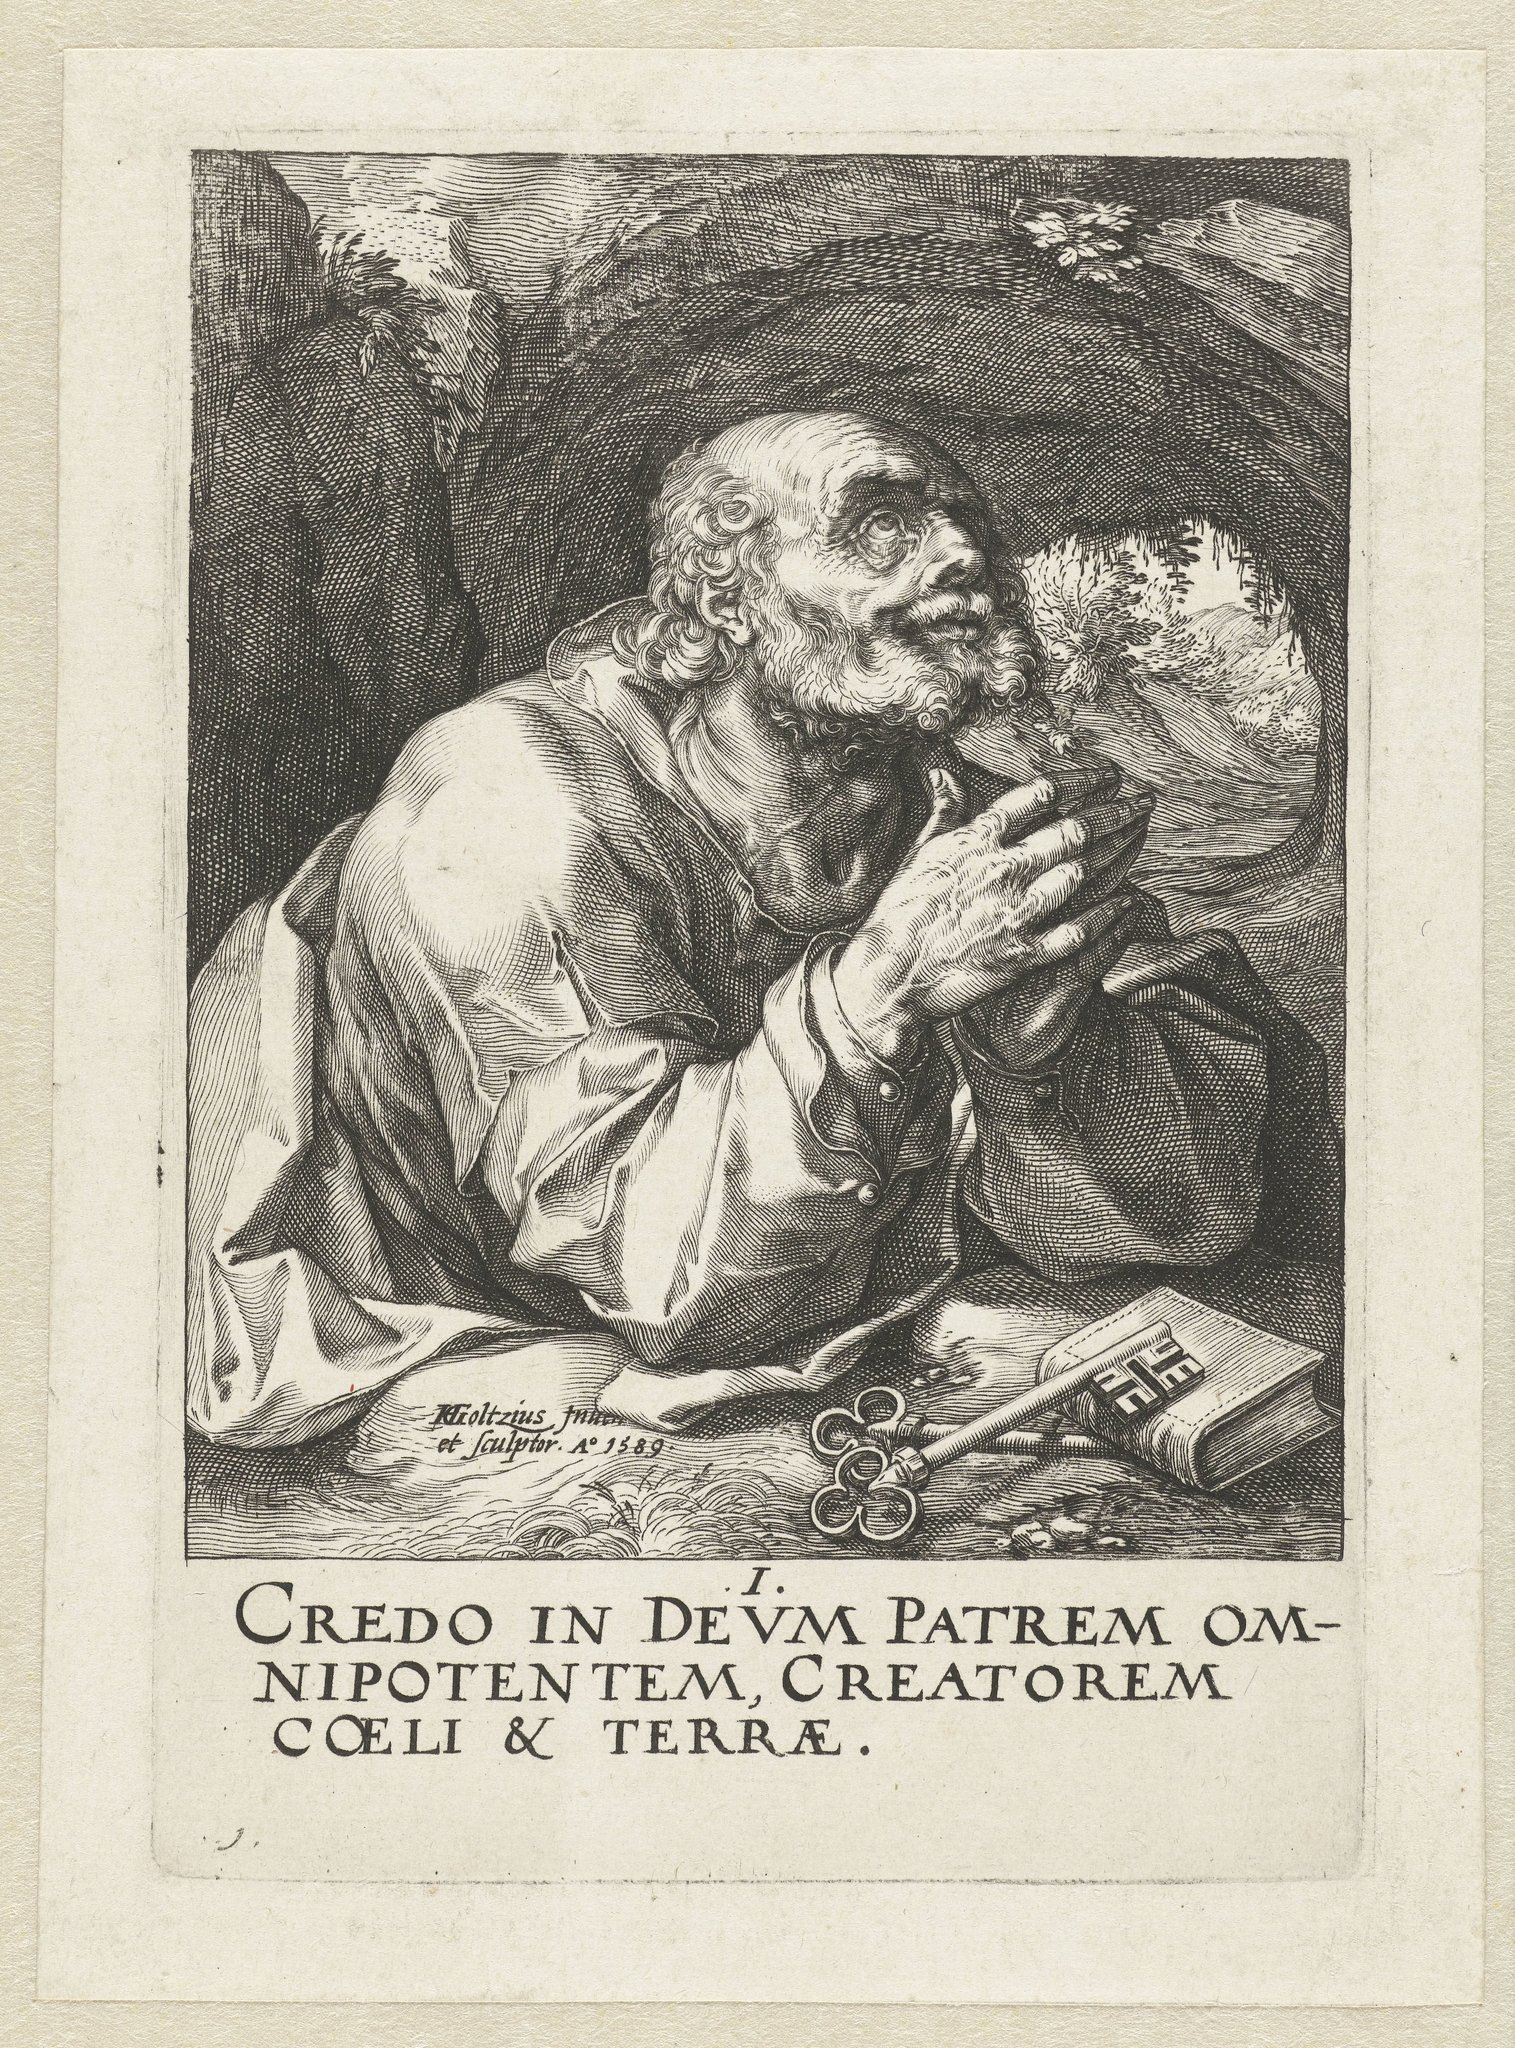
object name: print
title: Apostel Petrus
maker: hendrick goltzius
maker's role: draughtsman, painter, print maker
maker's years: 1558-1617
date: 1589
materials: paper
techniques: engraving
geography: haarlem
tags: the apostle peter, first bishop of rome; possible attributes: book, cock, (upturned) cross, (triple) crozier, fish, key, scroll, ship, tiara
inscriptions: collector's mark: Lugt 240, signature and date: ‘HGoltzius inuen et sculptor. Ao 1589.’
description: De heilige Petrus ten halven lijve, biddend. Twee sleutels en een boek voor zich. In marge onder de prent enkele regels Latijn. Prent uit een serie van veertien.